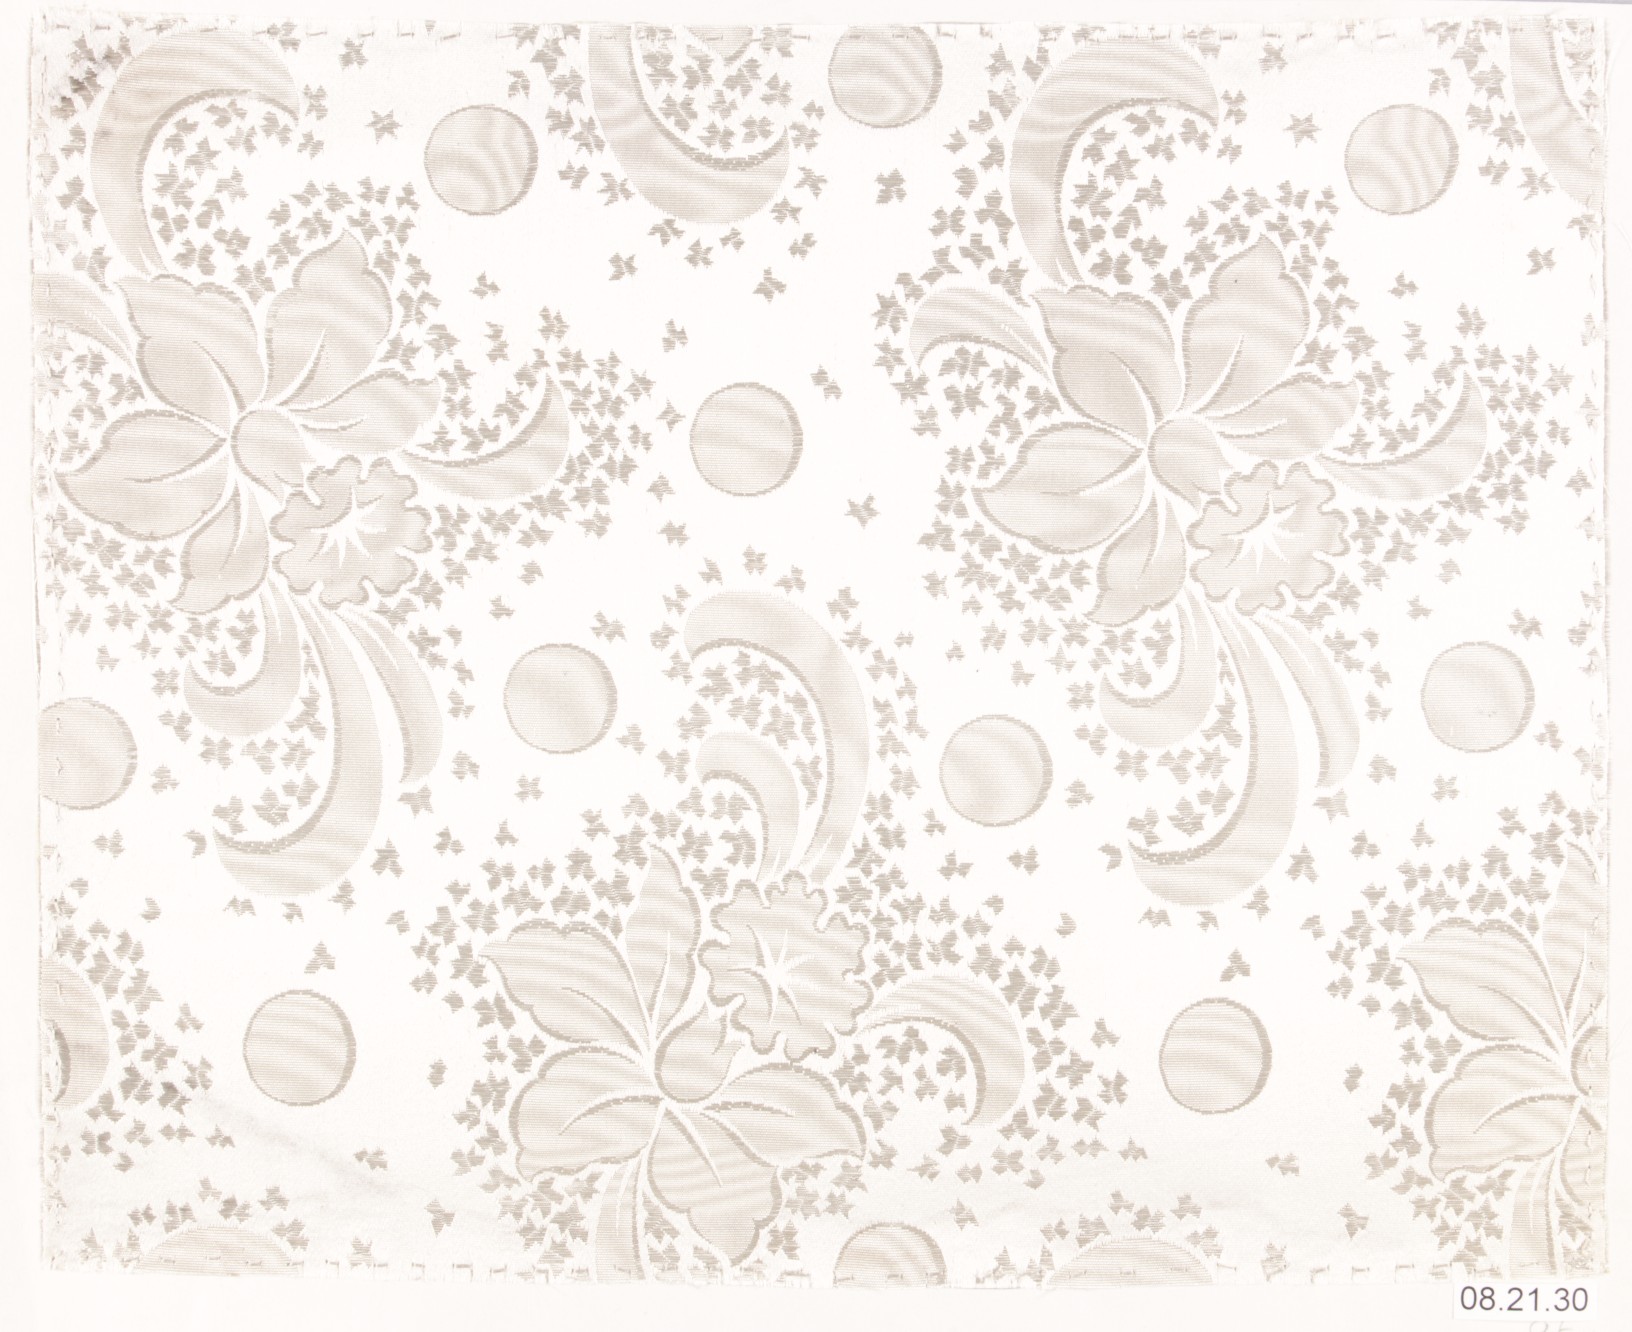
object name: textile sample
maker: Anonymous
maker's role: designer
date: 1900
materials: silk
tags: flowers